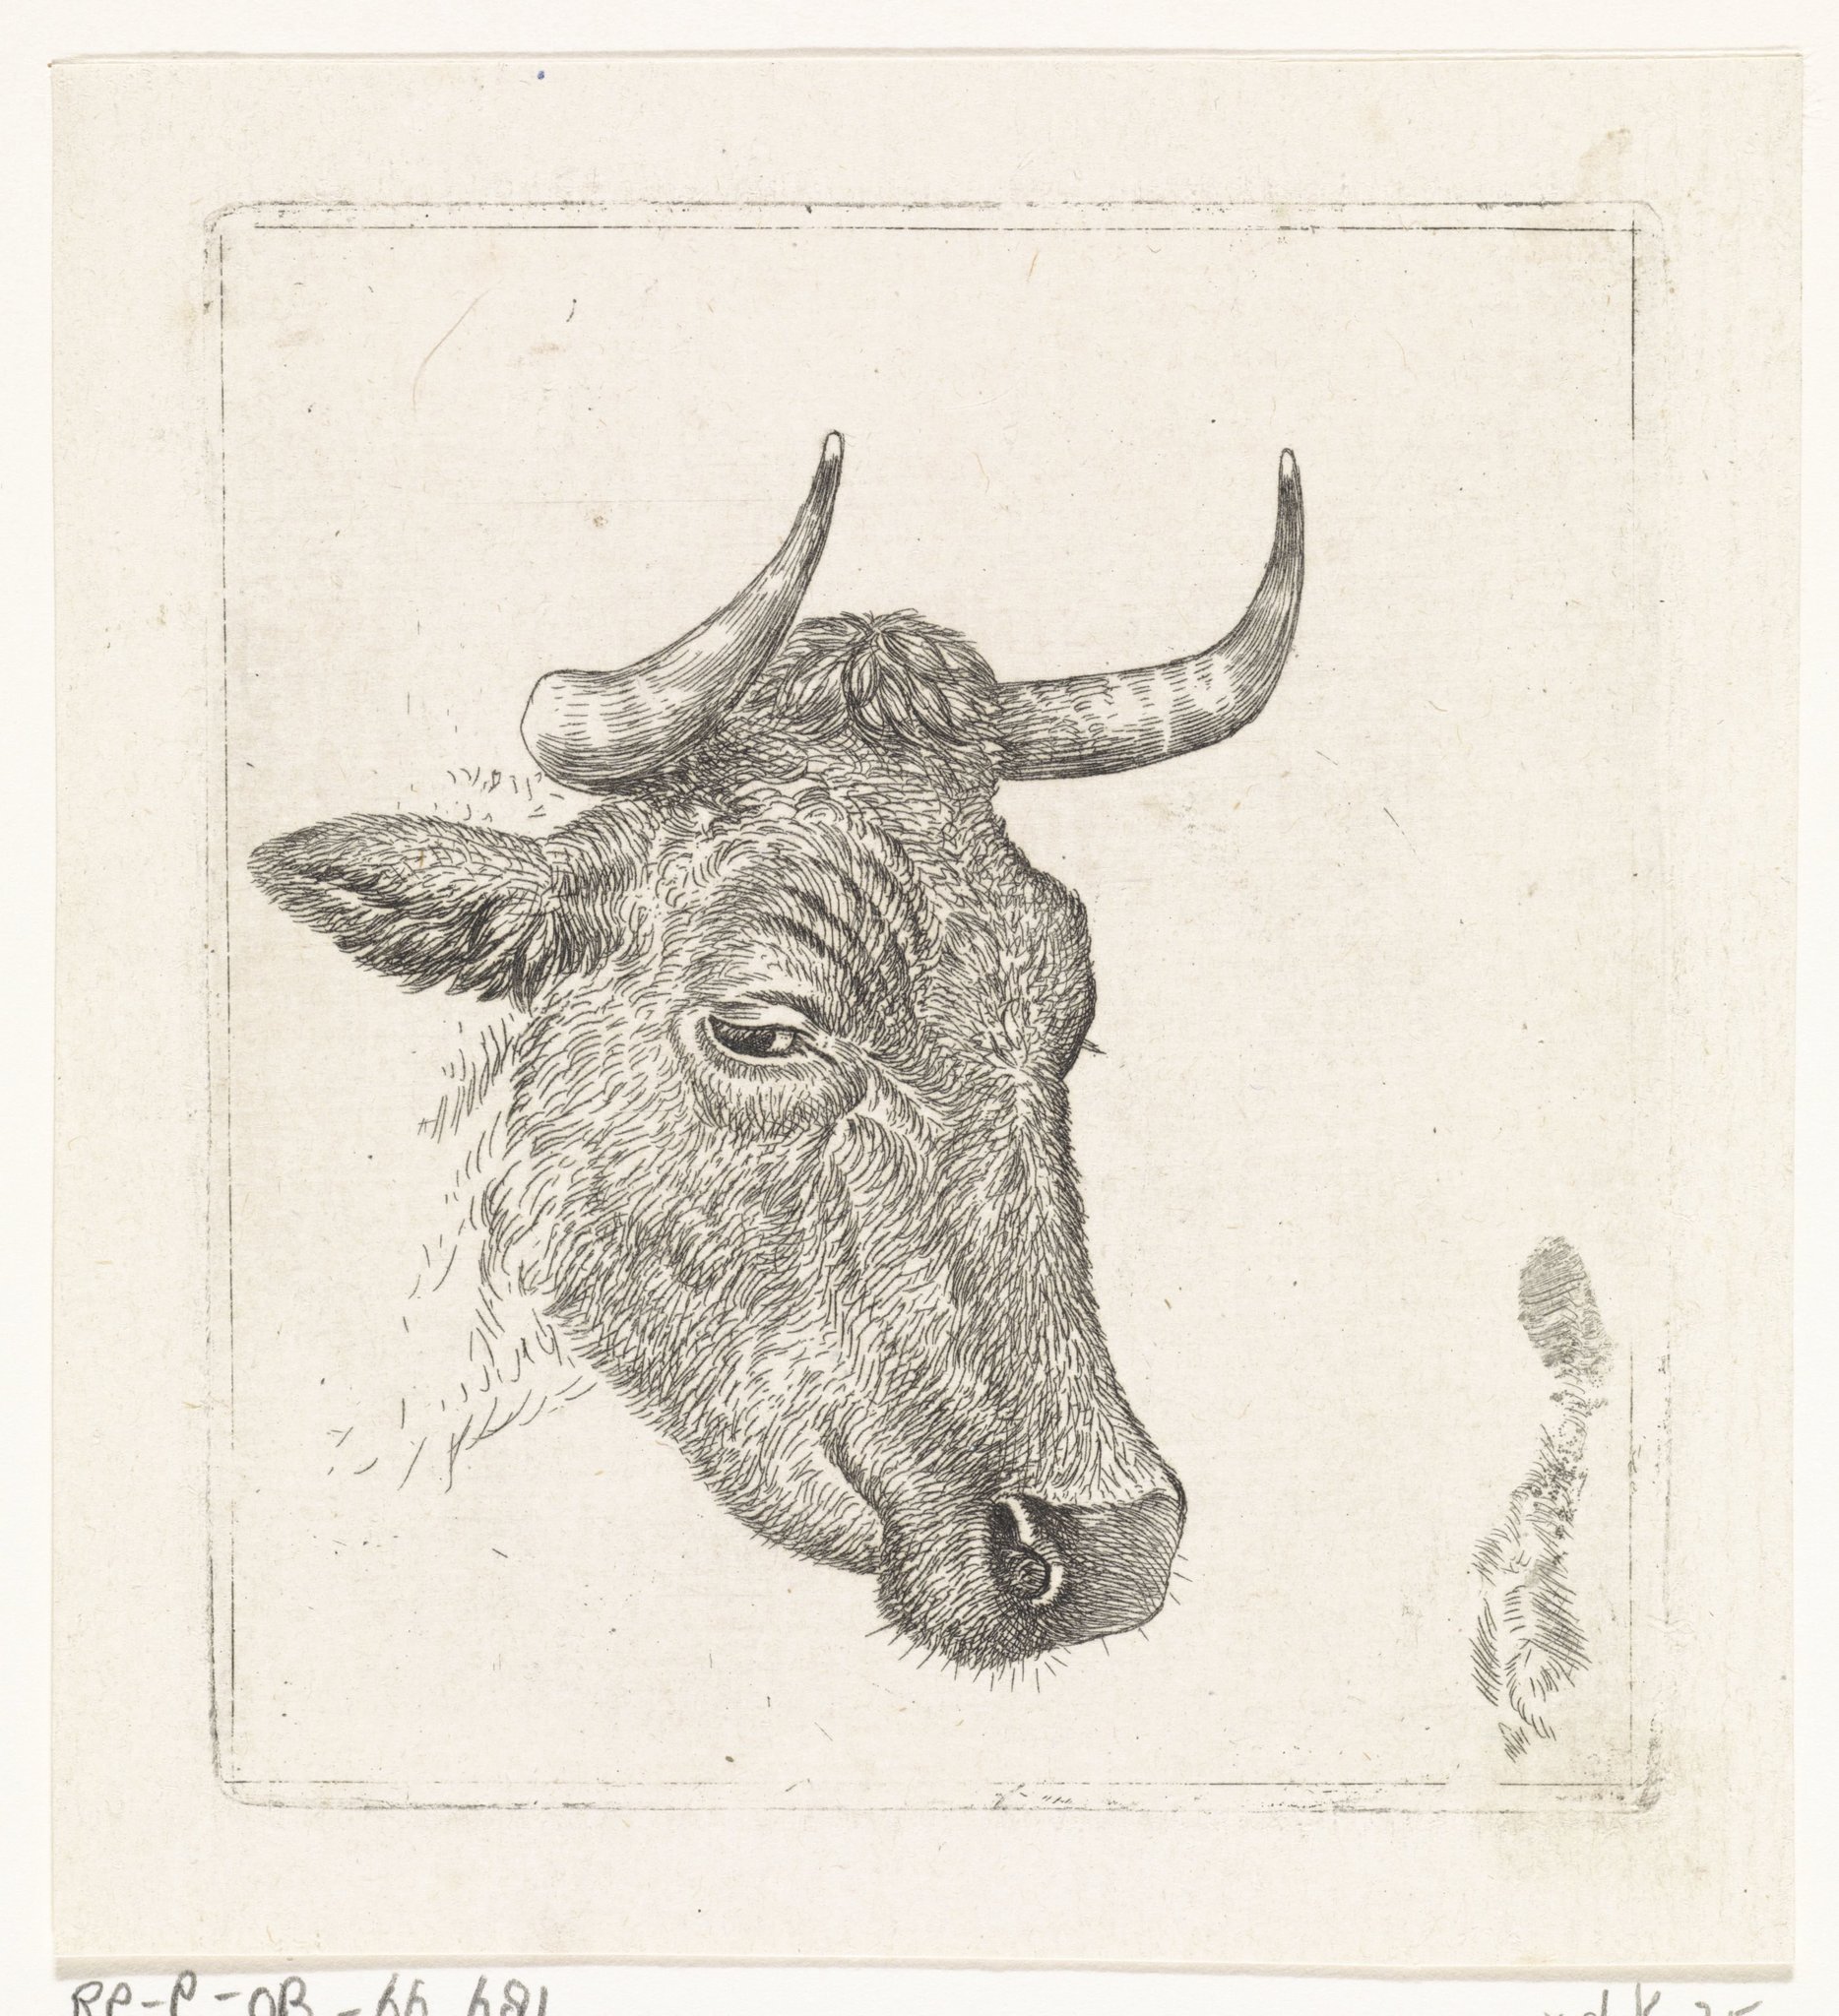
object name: print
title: Koeienkop A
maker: wouter johannes van troostwijk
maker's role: draughtsman, painter, print maker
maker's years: 1782-1810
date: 1792-1810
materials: paper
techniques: etching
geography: amsterdam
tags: cow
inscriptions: collector's mark: Lugt 2165